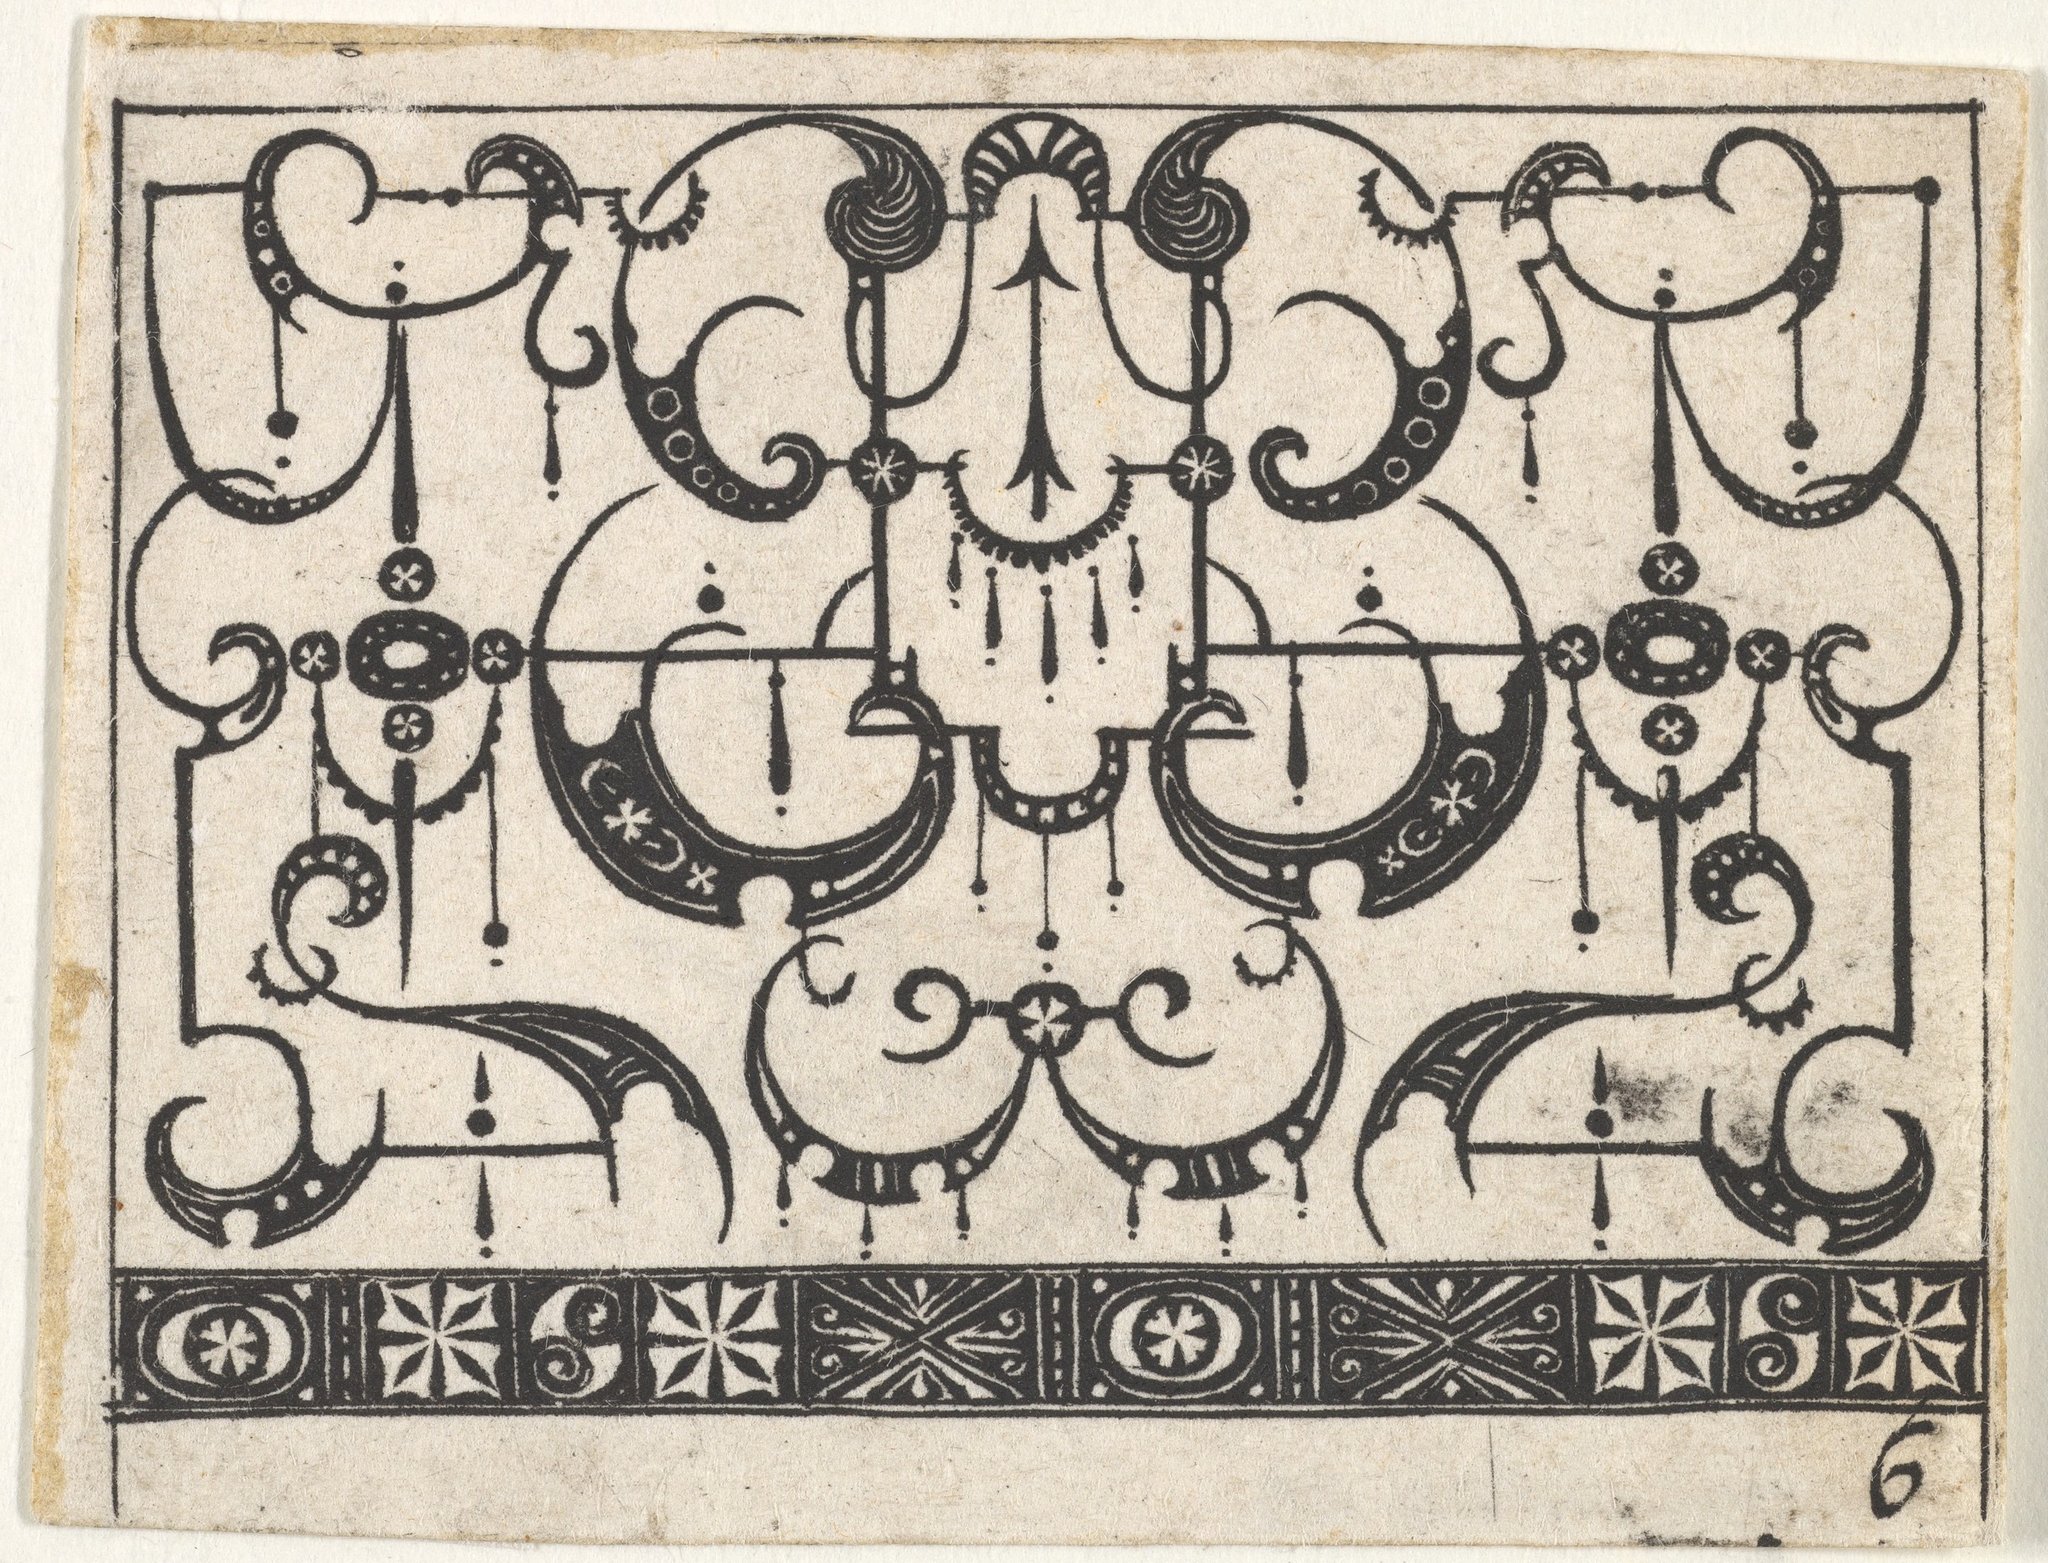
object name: print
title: Blackwork Print with an All-Over Schweifwerk Pattern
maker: claes jansz. visscher (ii)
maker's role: artist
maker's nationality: dutch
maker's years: 1586-1652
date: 1620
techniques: embroidery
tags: ornament